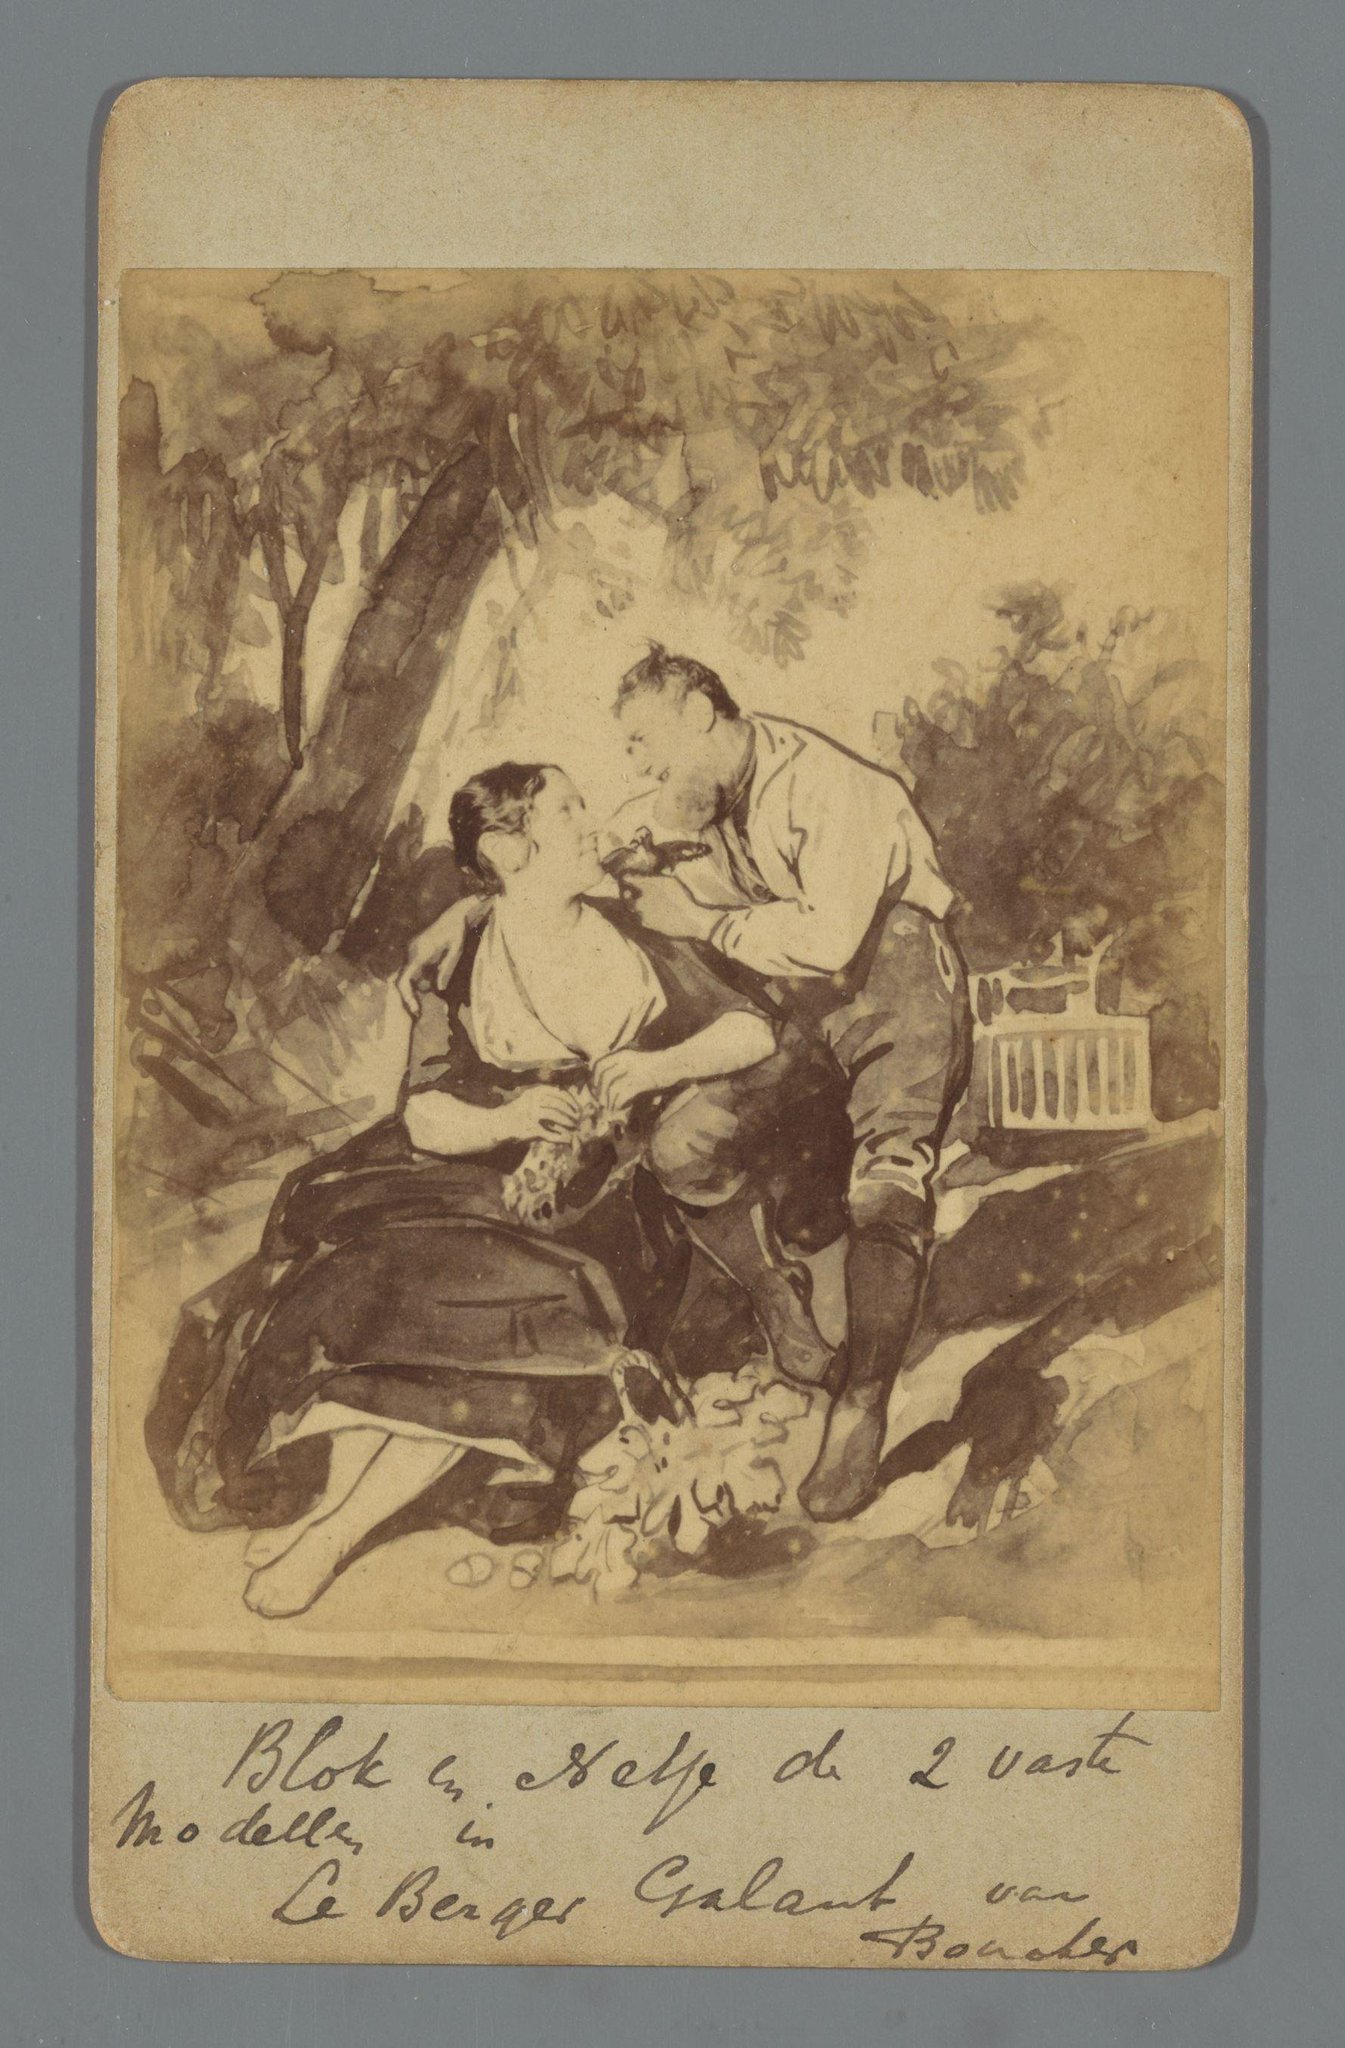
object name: photograph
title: De modellen Blok en Netje in een tableau vivant (?) naar Le Berger Galant van Boucher (Arti, Pulchri Studio)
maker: machiel hendricus laddé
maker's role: fotograaf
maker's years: 1866-1932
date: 1890-1900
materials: cardboard, photographic support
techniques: albumen print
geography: amsterdam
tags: 'tableau vivant'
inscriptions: : ‘MHL / M.H. Laddé / AMSTERDAM’, annotation: ‘Blok en Netje de 2 vaste / modellen in / Le Berger Galant van / Boucher’